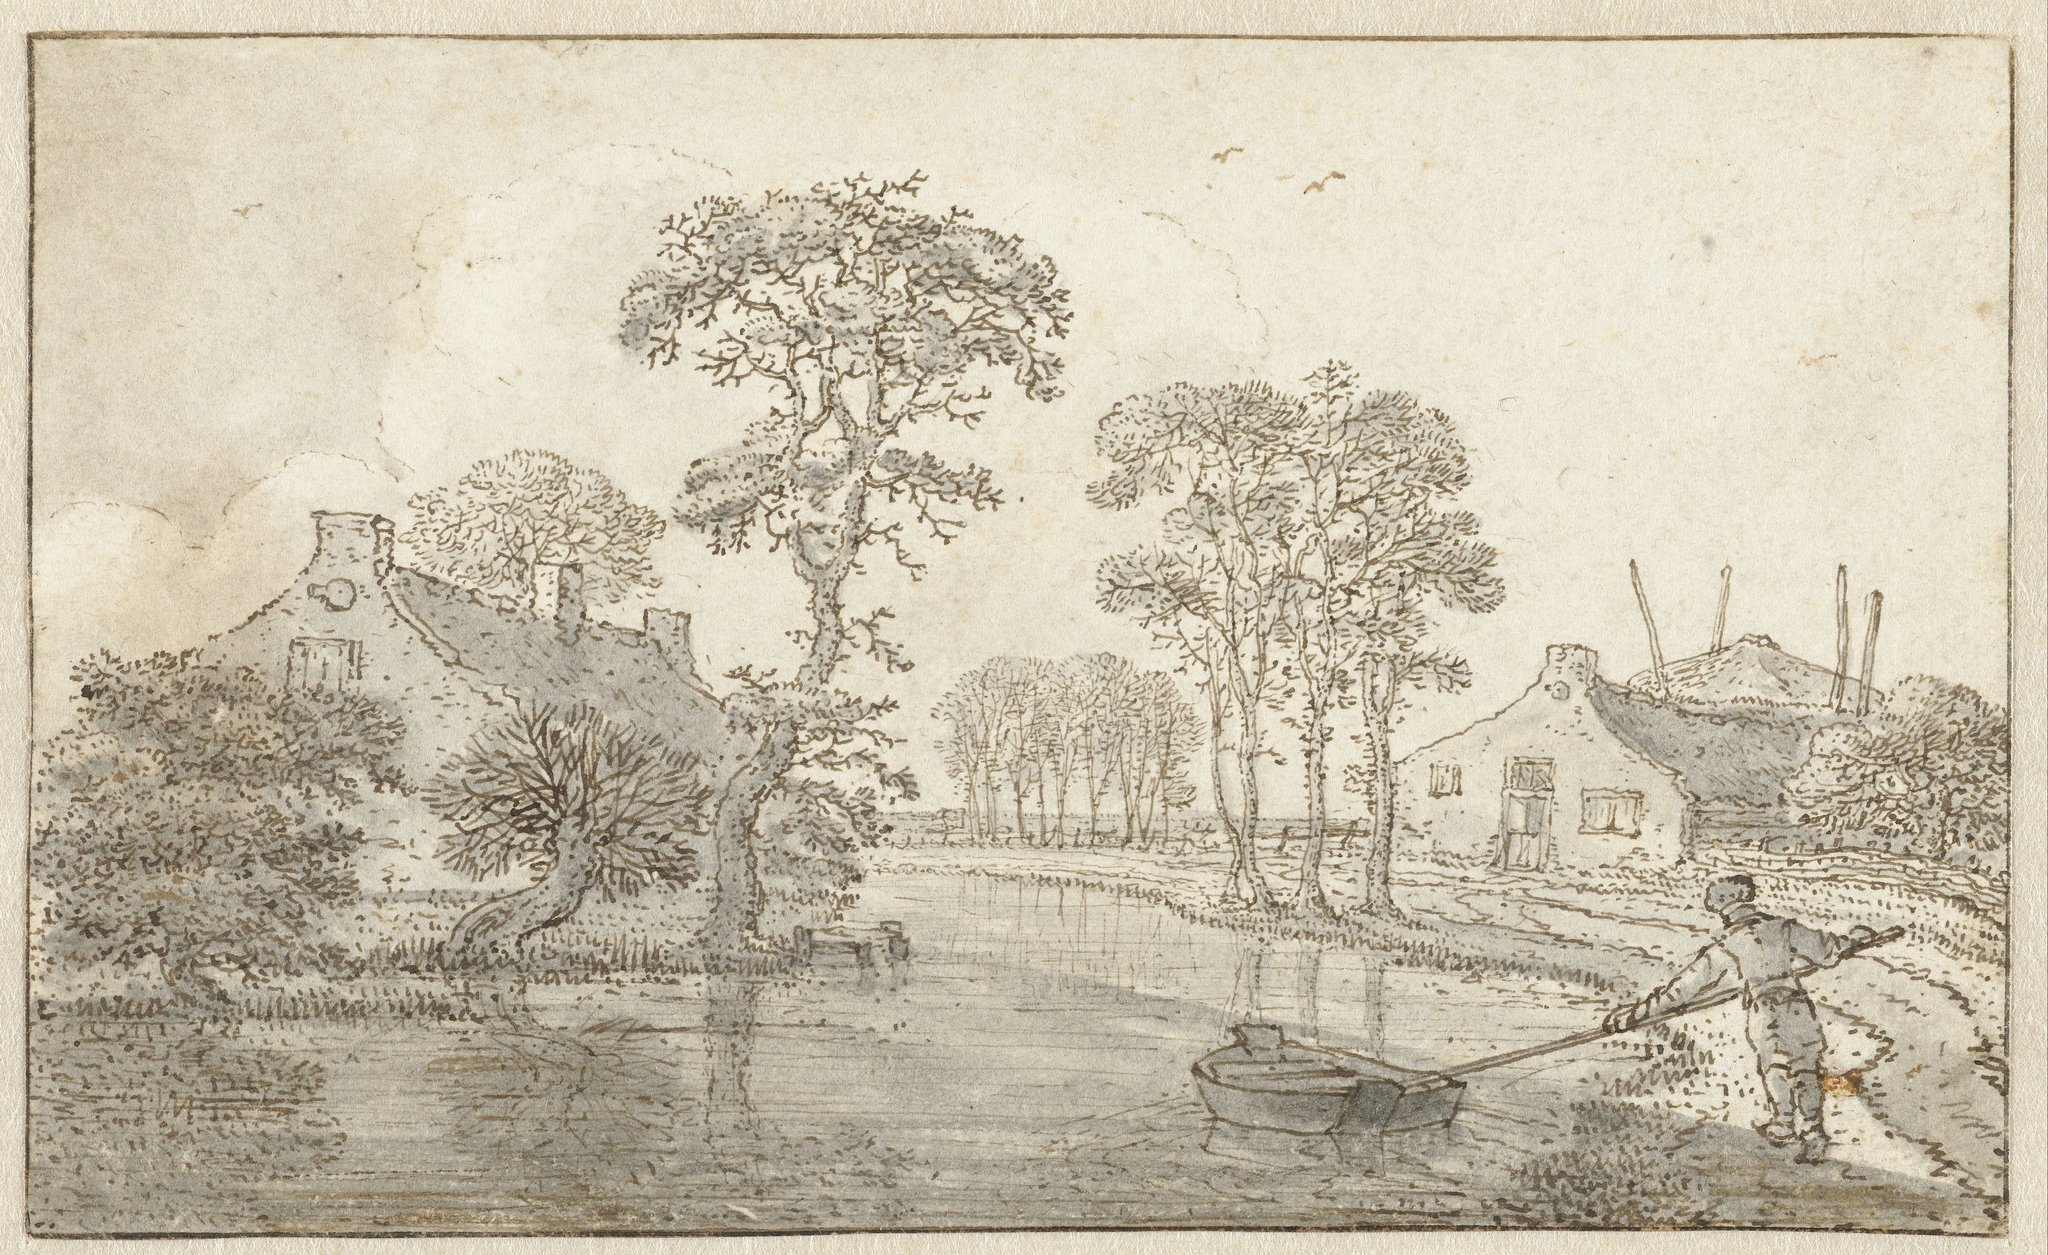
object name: drawing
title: Landschap met twee huizen aan een water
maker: jan jansz. den uyl (ii)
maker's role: draughtsman, print maker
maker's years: 1621-1669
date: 1634-1702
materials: ink, paper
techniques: brush, pen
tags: landscapes with waters, waterscapes, seascapes (in the temperate zone), farm (building)